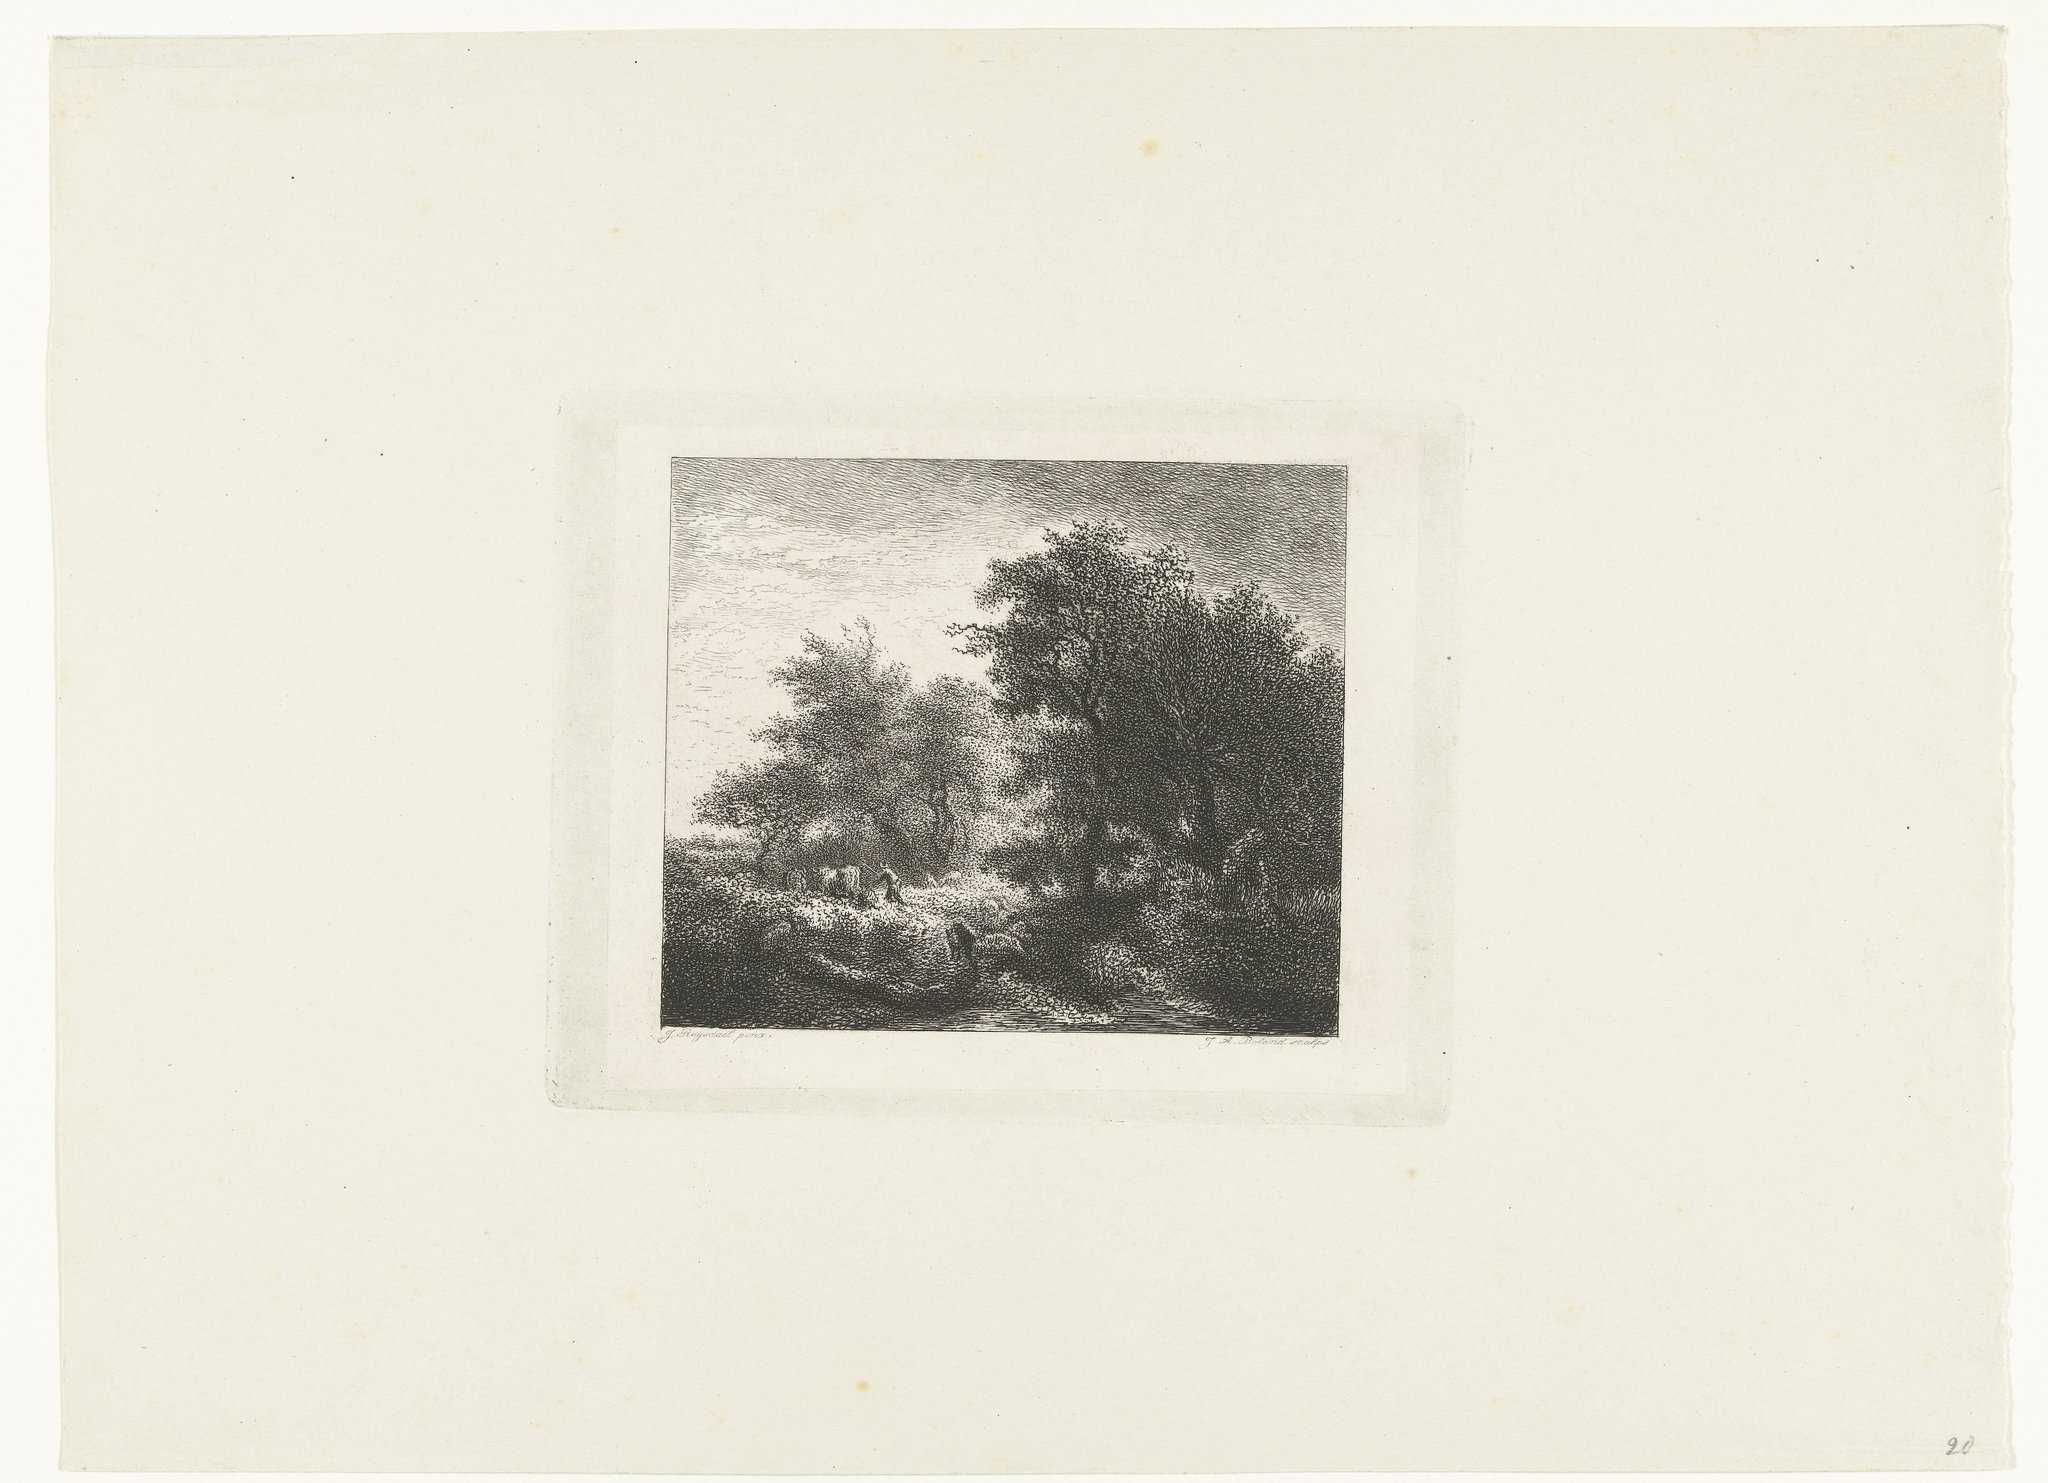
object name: print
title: Bosgezicht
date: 1860-1900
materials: paper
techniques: etching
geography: amsterdam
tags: forest, wood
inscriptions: collector's mark: Lugt 2228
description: Coll. de la Faille. Reproductie van een schilderij uit de collectie van het Rijksmuseum Amsterdam, SK-A-350.